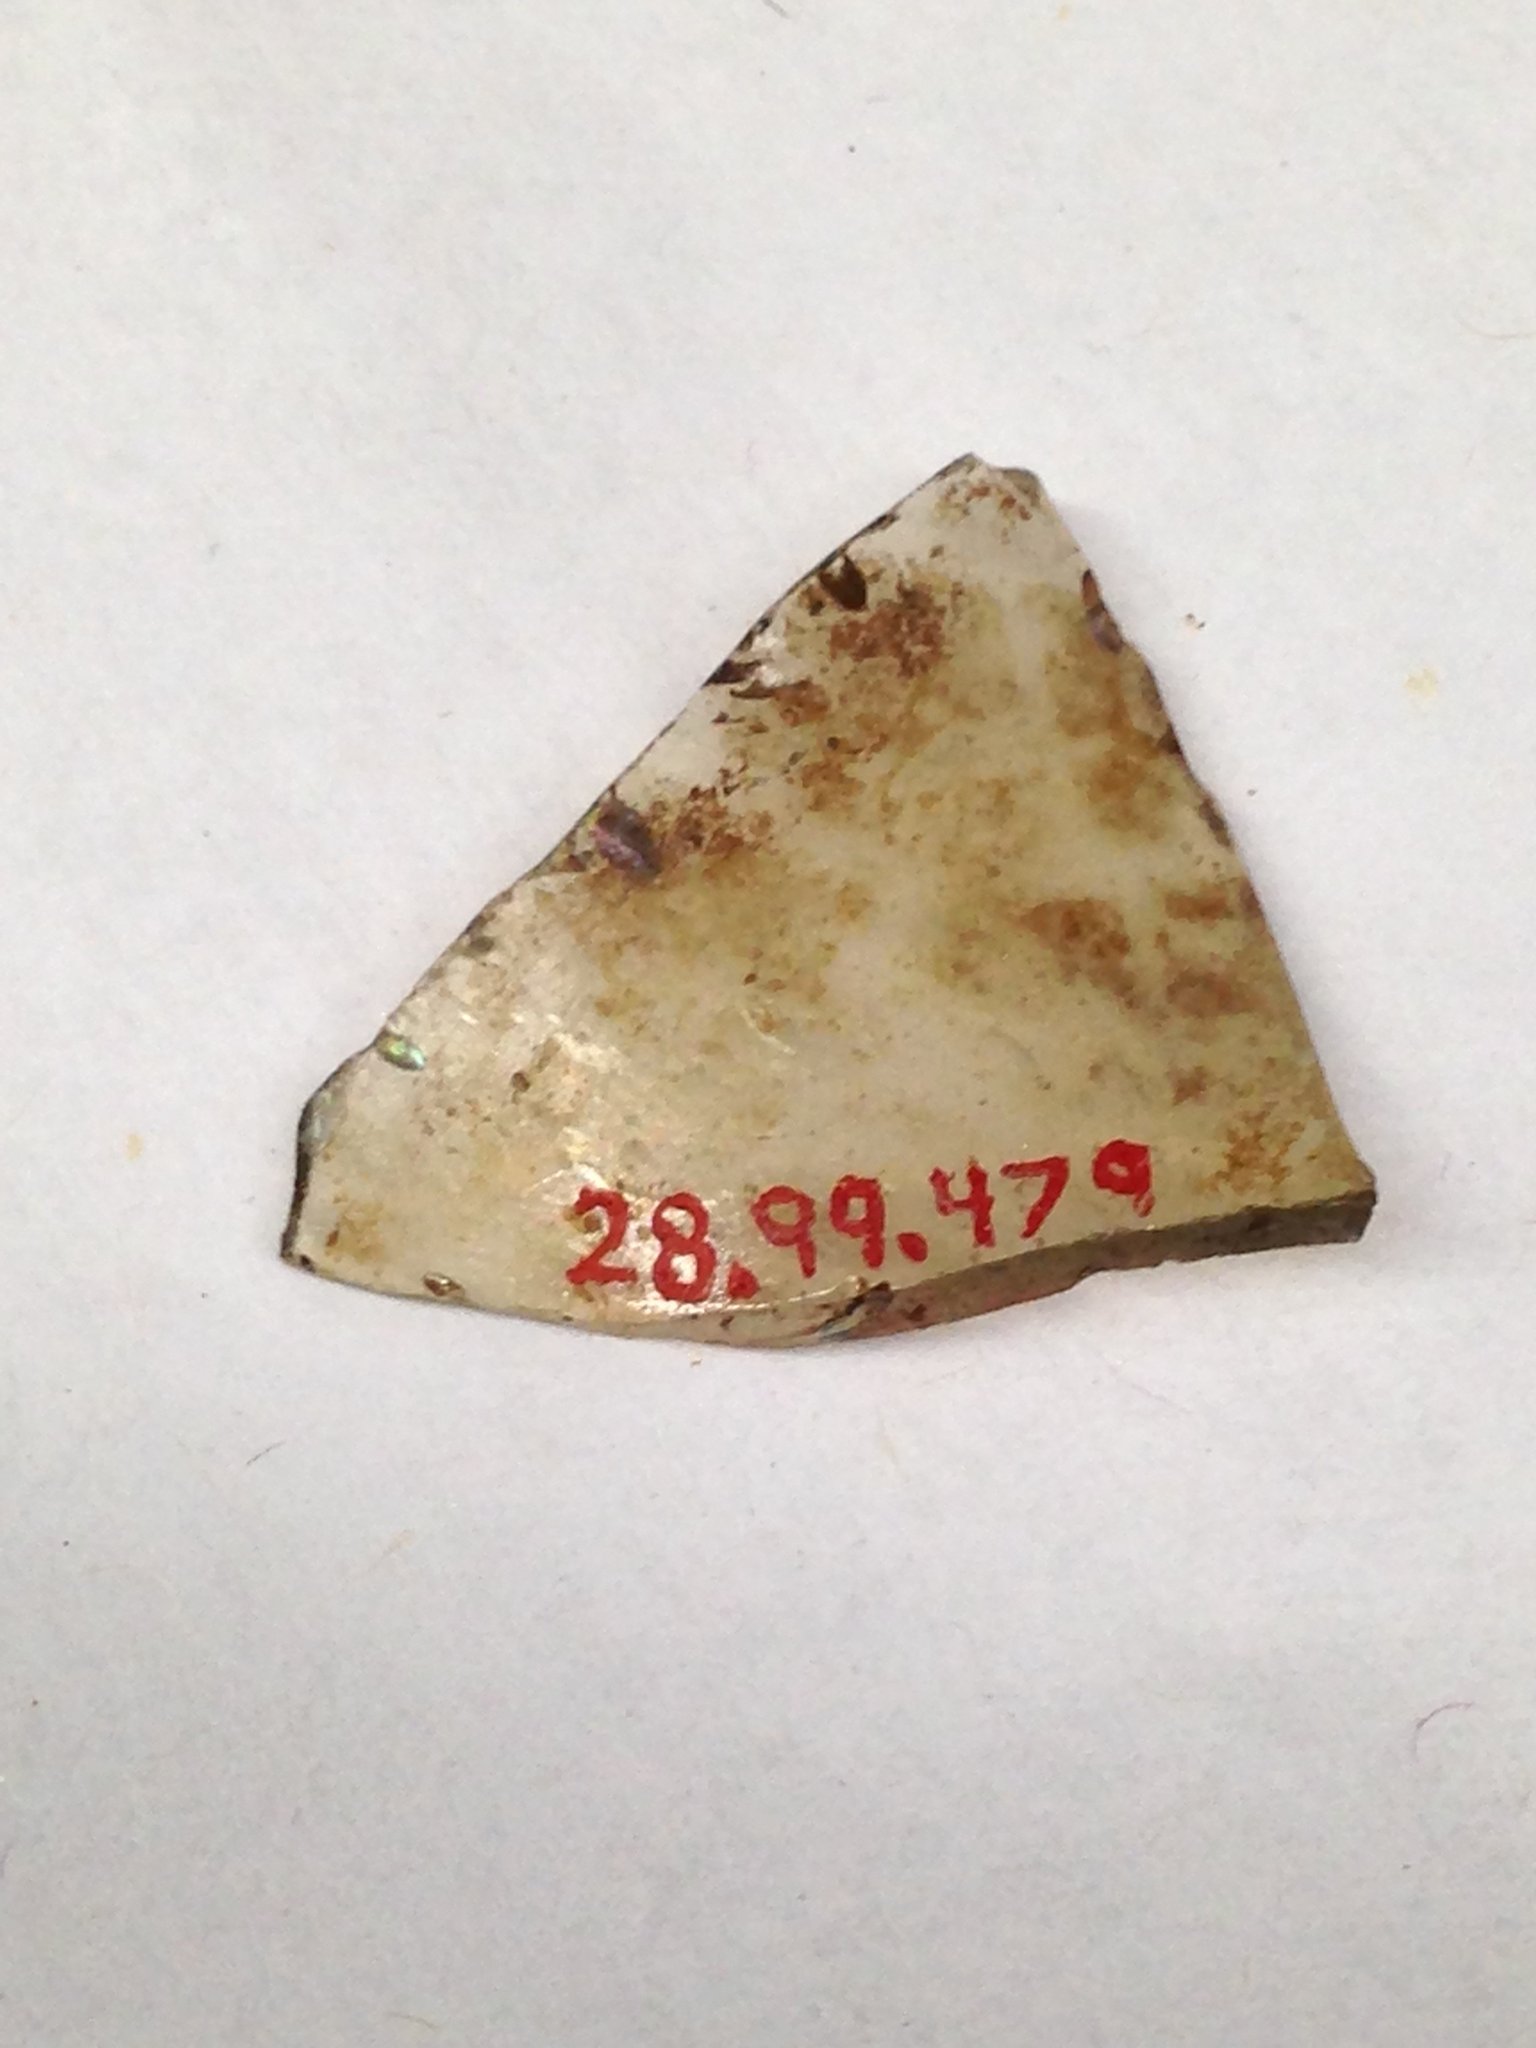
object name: fragment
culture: european or middle eastern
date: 1150-1250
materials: ceramic, glass